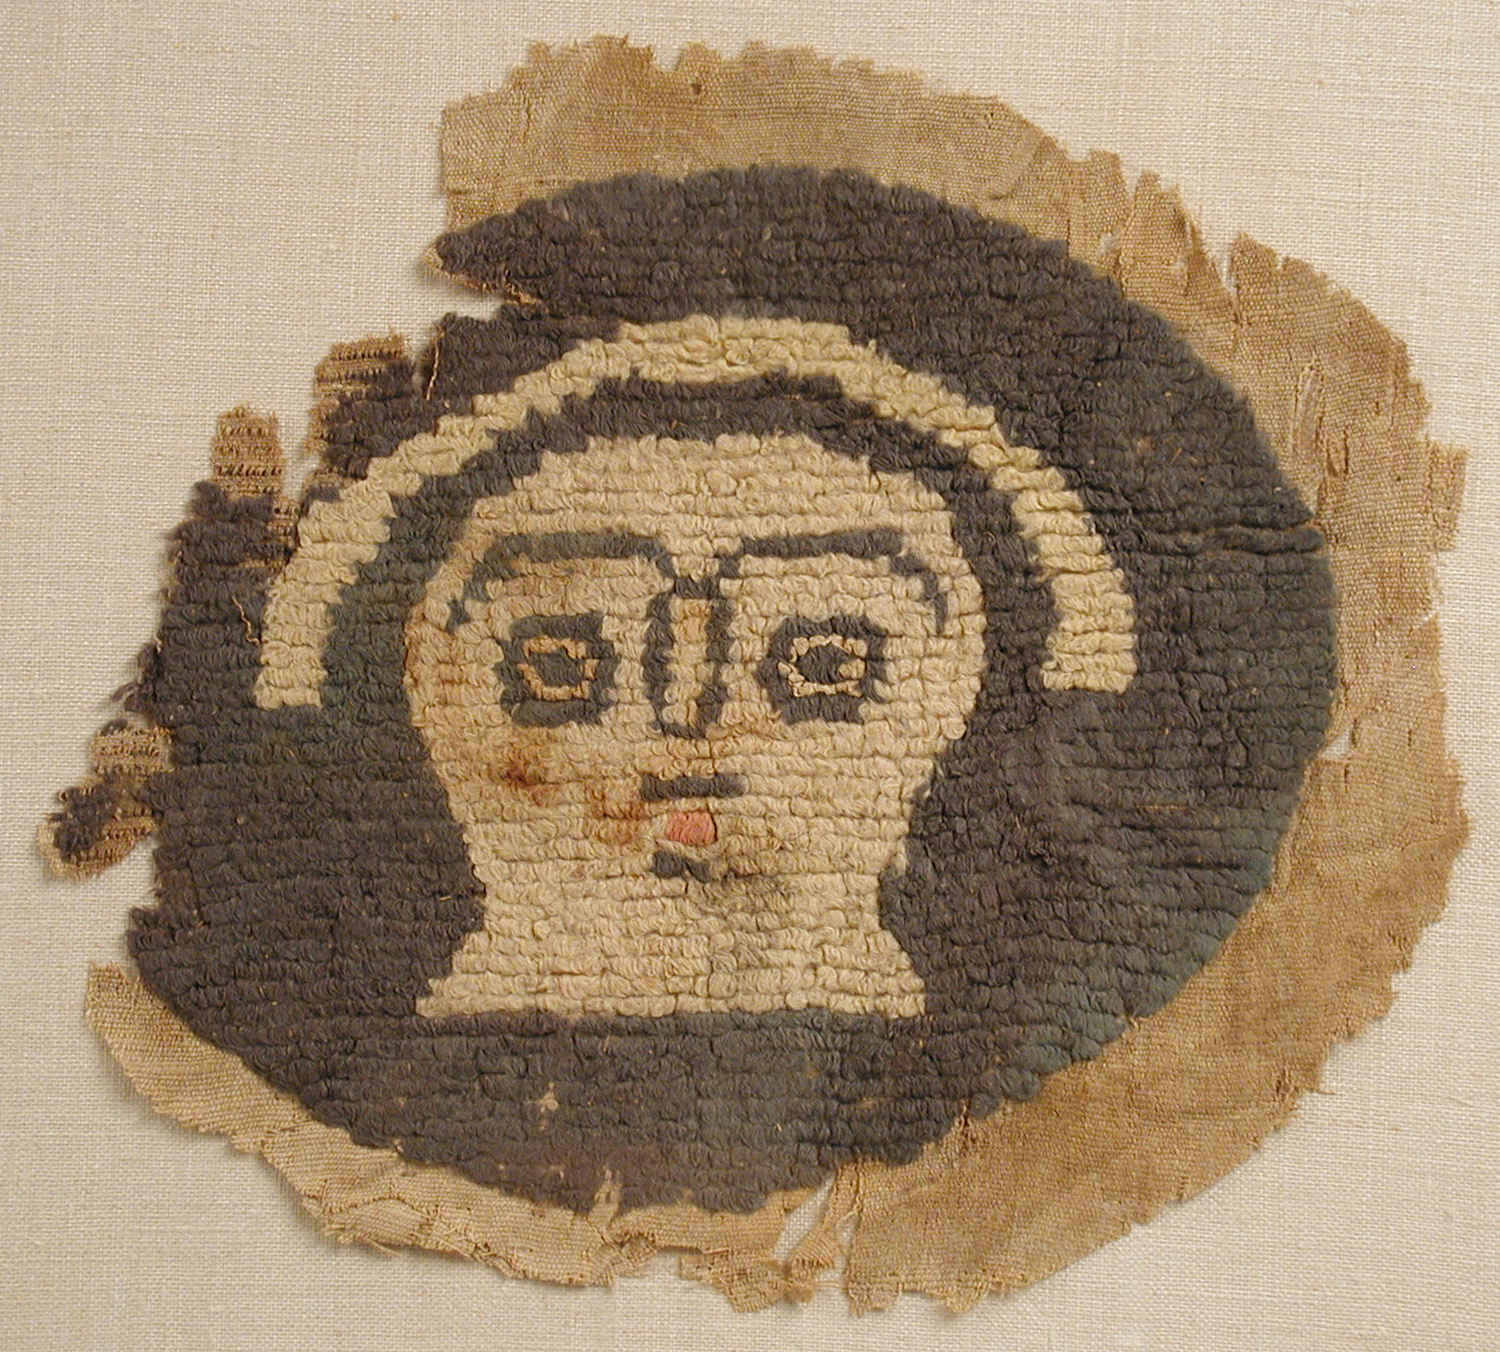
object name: textile fragment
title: Roundel with Human Face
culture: coptic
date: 401-500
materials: linen, wool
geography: egypt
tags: faces